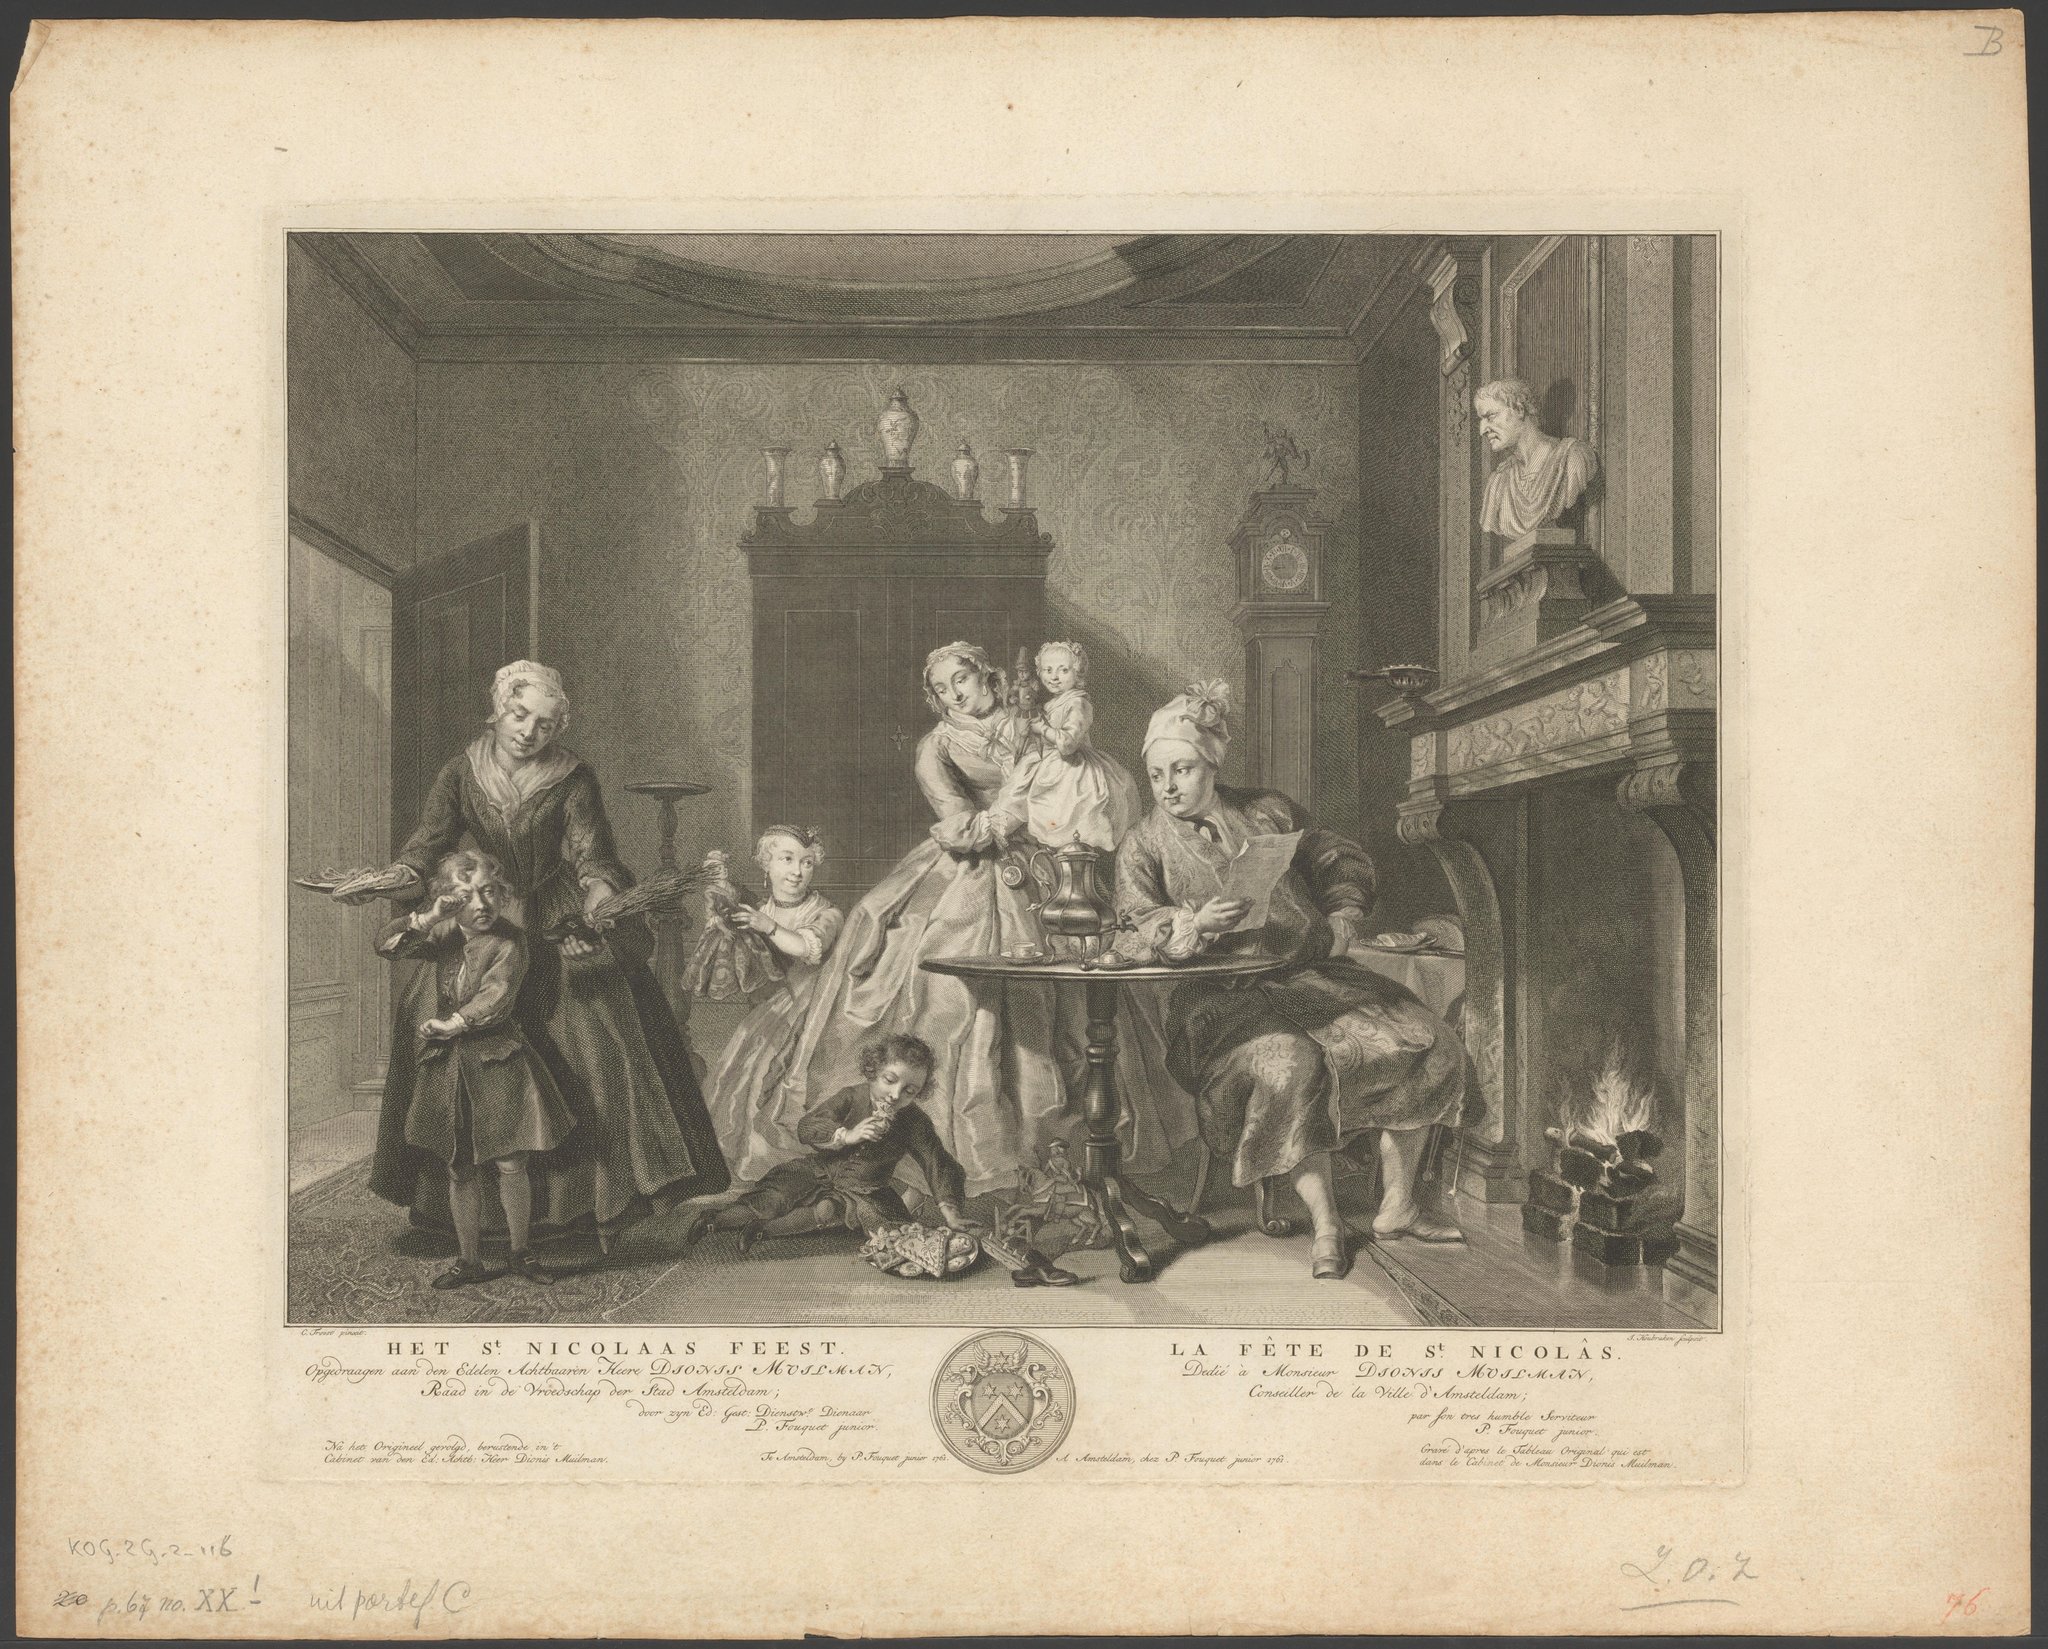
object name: print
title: Sint Nicolaasfeest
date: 1761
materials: paper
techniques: engraving, etching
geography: amsterdam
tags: parents with their children, cake, tart, pastry, open hearth, fire-place, (playing with) dolls, festivities on st. nicholas (eve) (december 5), family life at home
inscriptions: collector's mark: Lugt 2488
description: In een interieur viert een gezin het Sint Nicolaasfeest. De vader zit bij de haard te lezen, achter hem laten twee dochters hun poppen zien die ze hebben gekregen. Op de grond snoept een kind met een schaal met koek en snoepgoed. Links een huilende jongen die alleen een roe heeft gekregen; de dienstmeid achter hem heeft zijn schoen met daarin de roe vast.